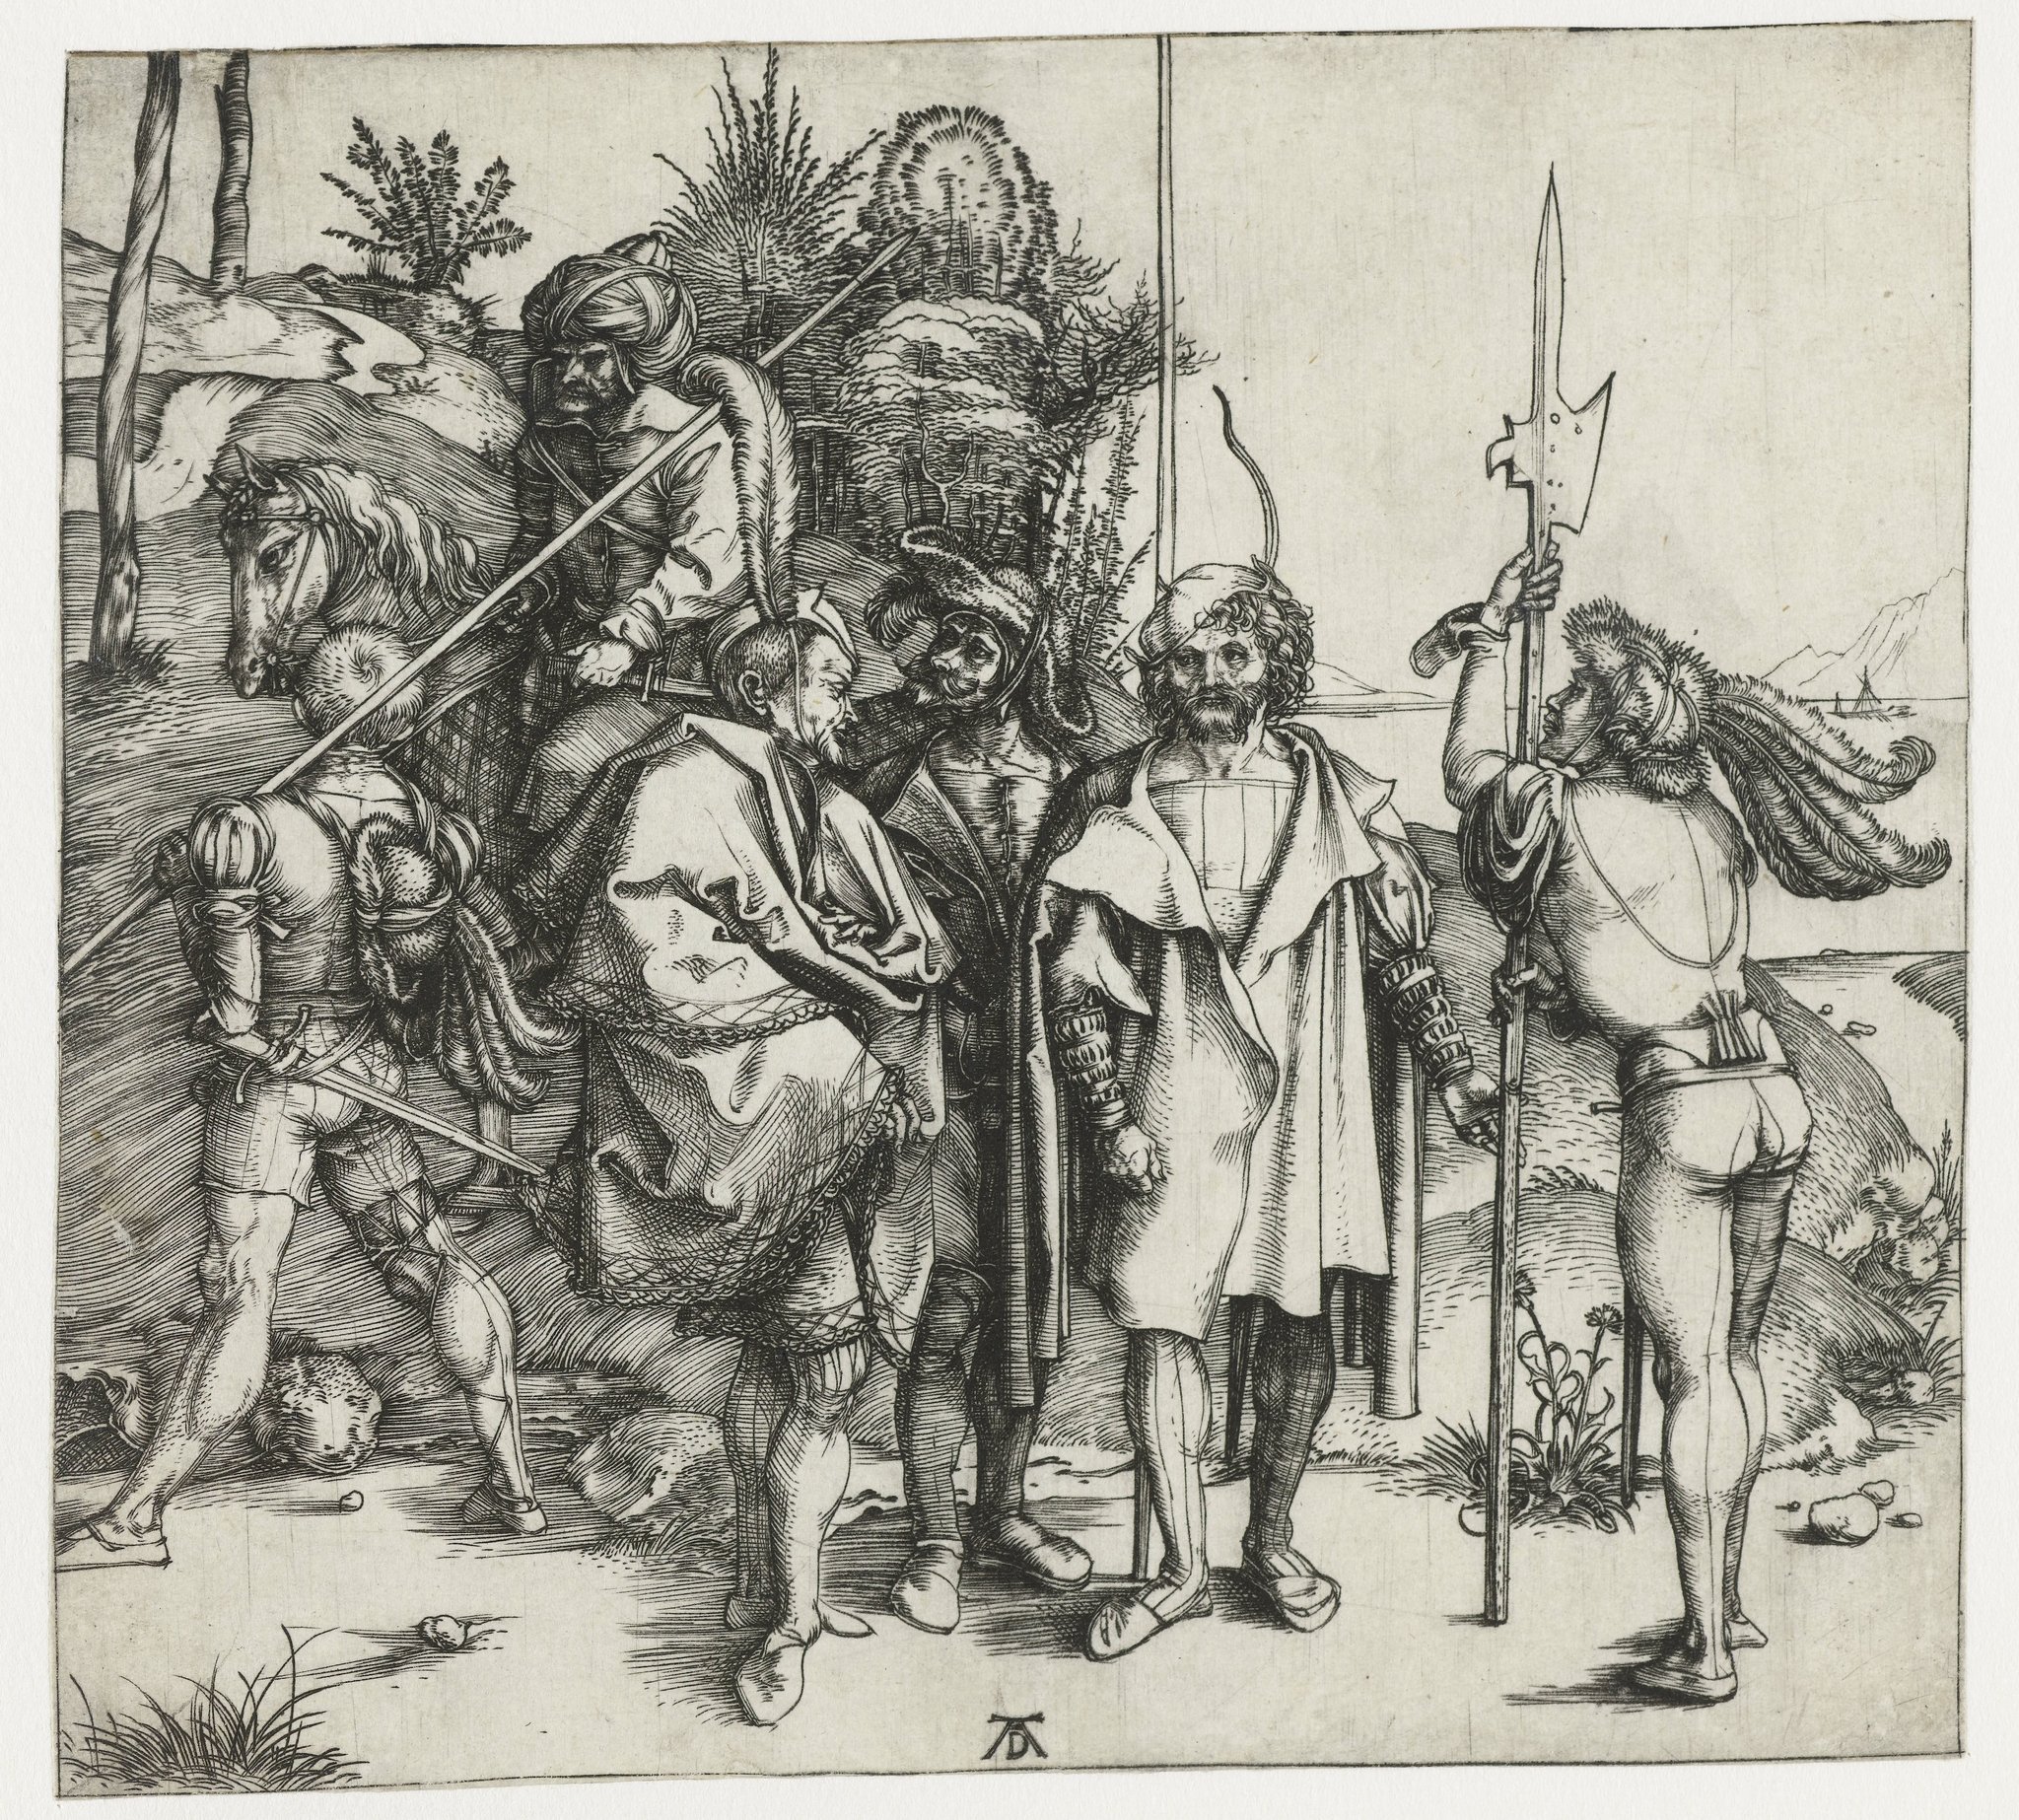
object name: print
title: Vijf soldaten en een oosterse ruiter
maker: albrecht dürer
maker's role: draughtsman, painter, print maker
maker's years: 1471-1528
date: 1493-1498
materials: paper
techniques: engraving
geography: nuremberg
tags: riding a horse, ass, or mule; rider, horseman, asiatic races and peoples: turks, private soldier, warfare; military affairs (+ mercenary troops, e.g.: lansquenets), clothes, costume (+ men's clothes), shoes, sandals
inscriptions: collector's mark: Lugt 2228a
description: Groep van vijf staande landsknechten, gekleed volgens de Duitse mode van ca. 1490-1500. Achter hen een oosterse ruiter. De mannen dragen beenlingen als beenbekleding en schoenen met ronde neuzen. De man rechts heeft een bontmuts met veren op het hoofd, de man linksvoor een ronde muts met veer, middenachter: hoed met grote rand. De man middenvoor draagt een mantel met grote platte kraag.